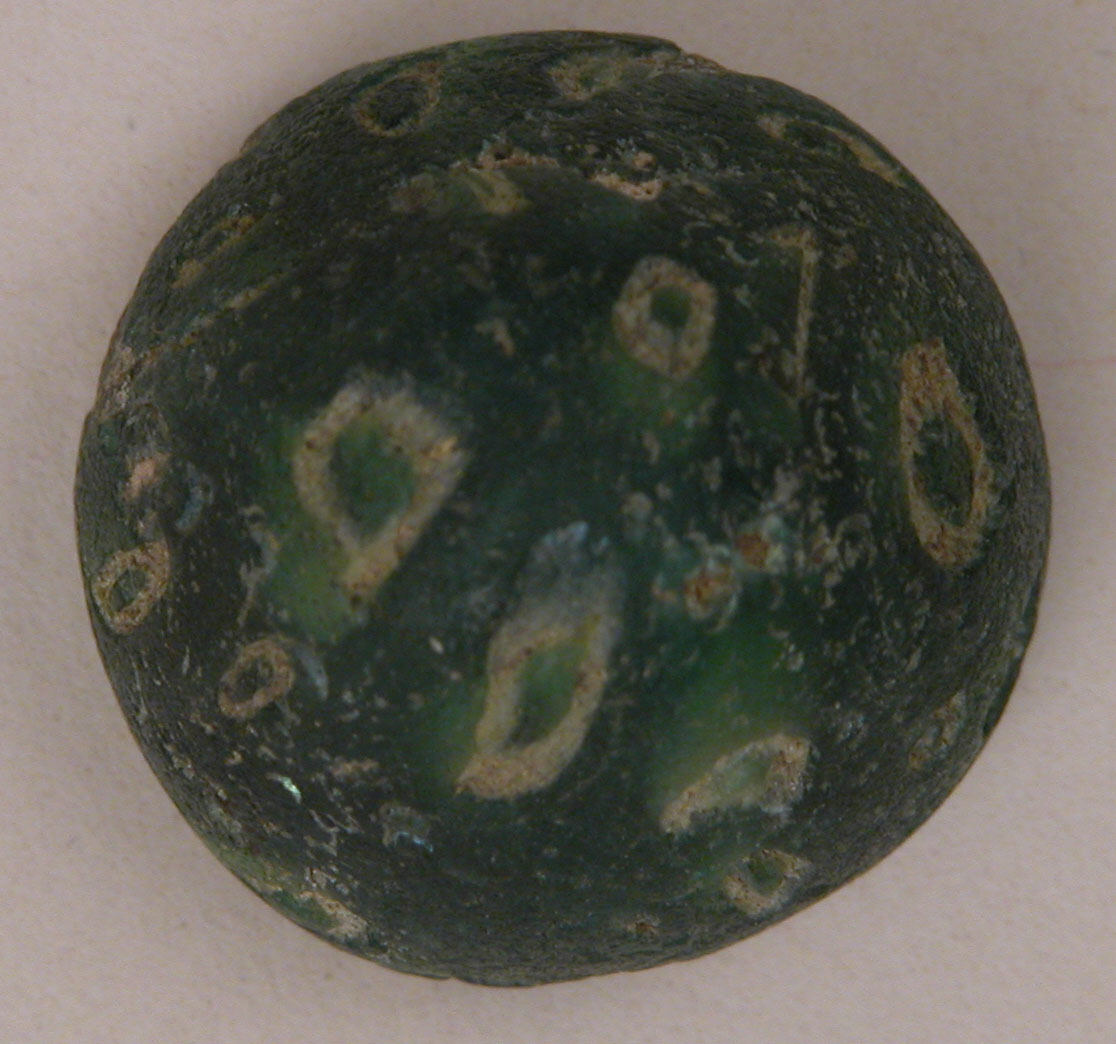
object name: gaming piece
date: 701-1200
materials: glass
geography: islamic lands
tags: games